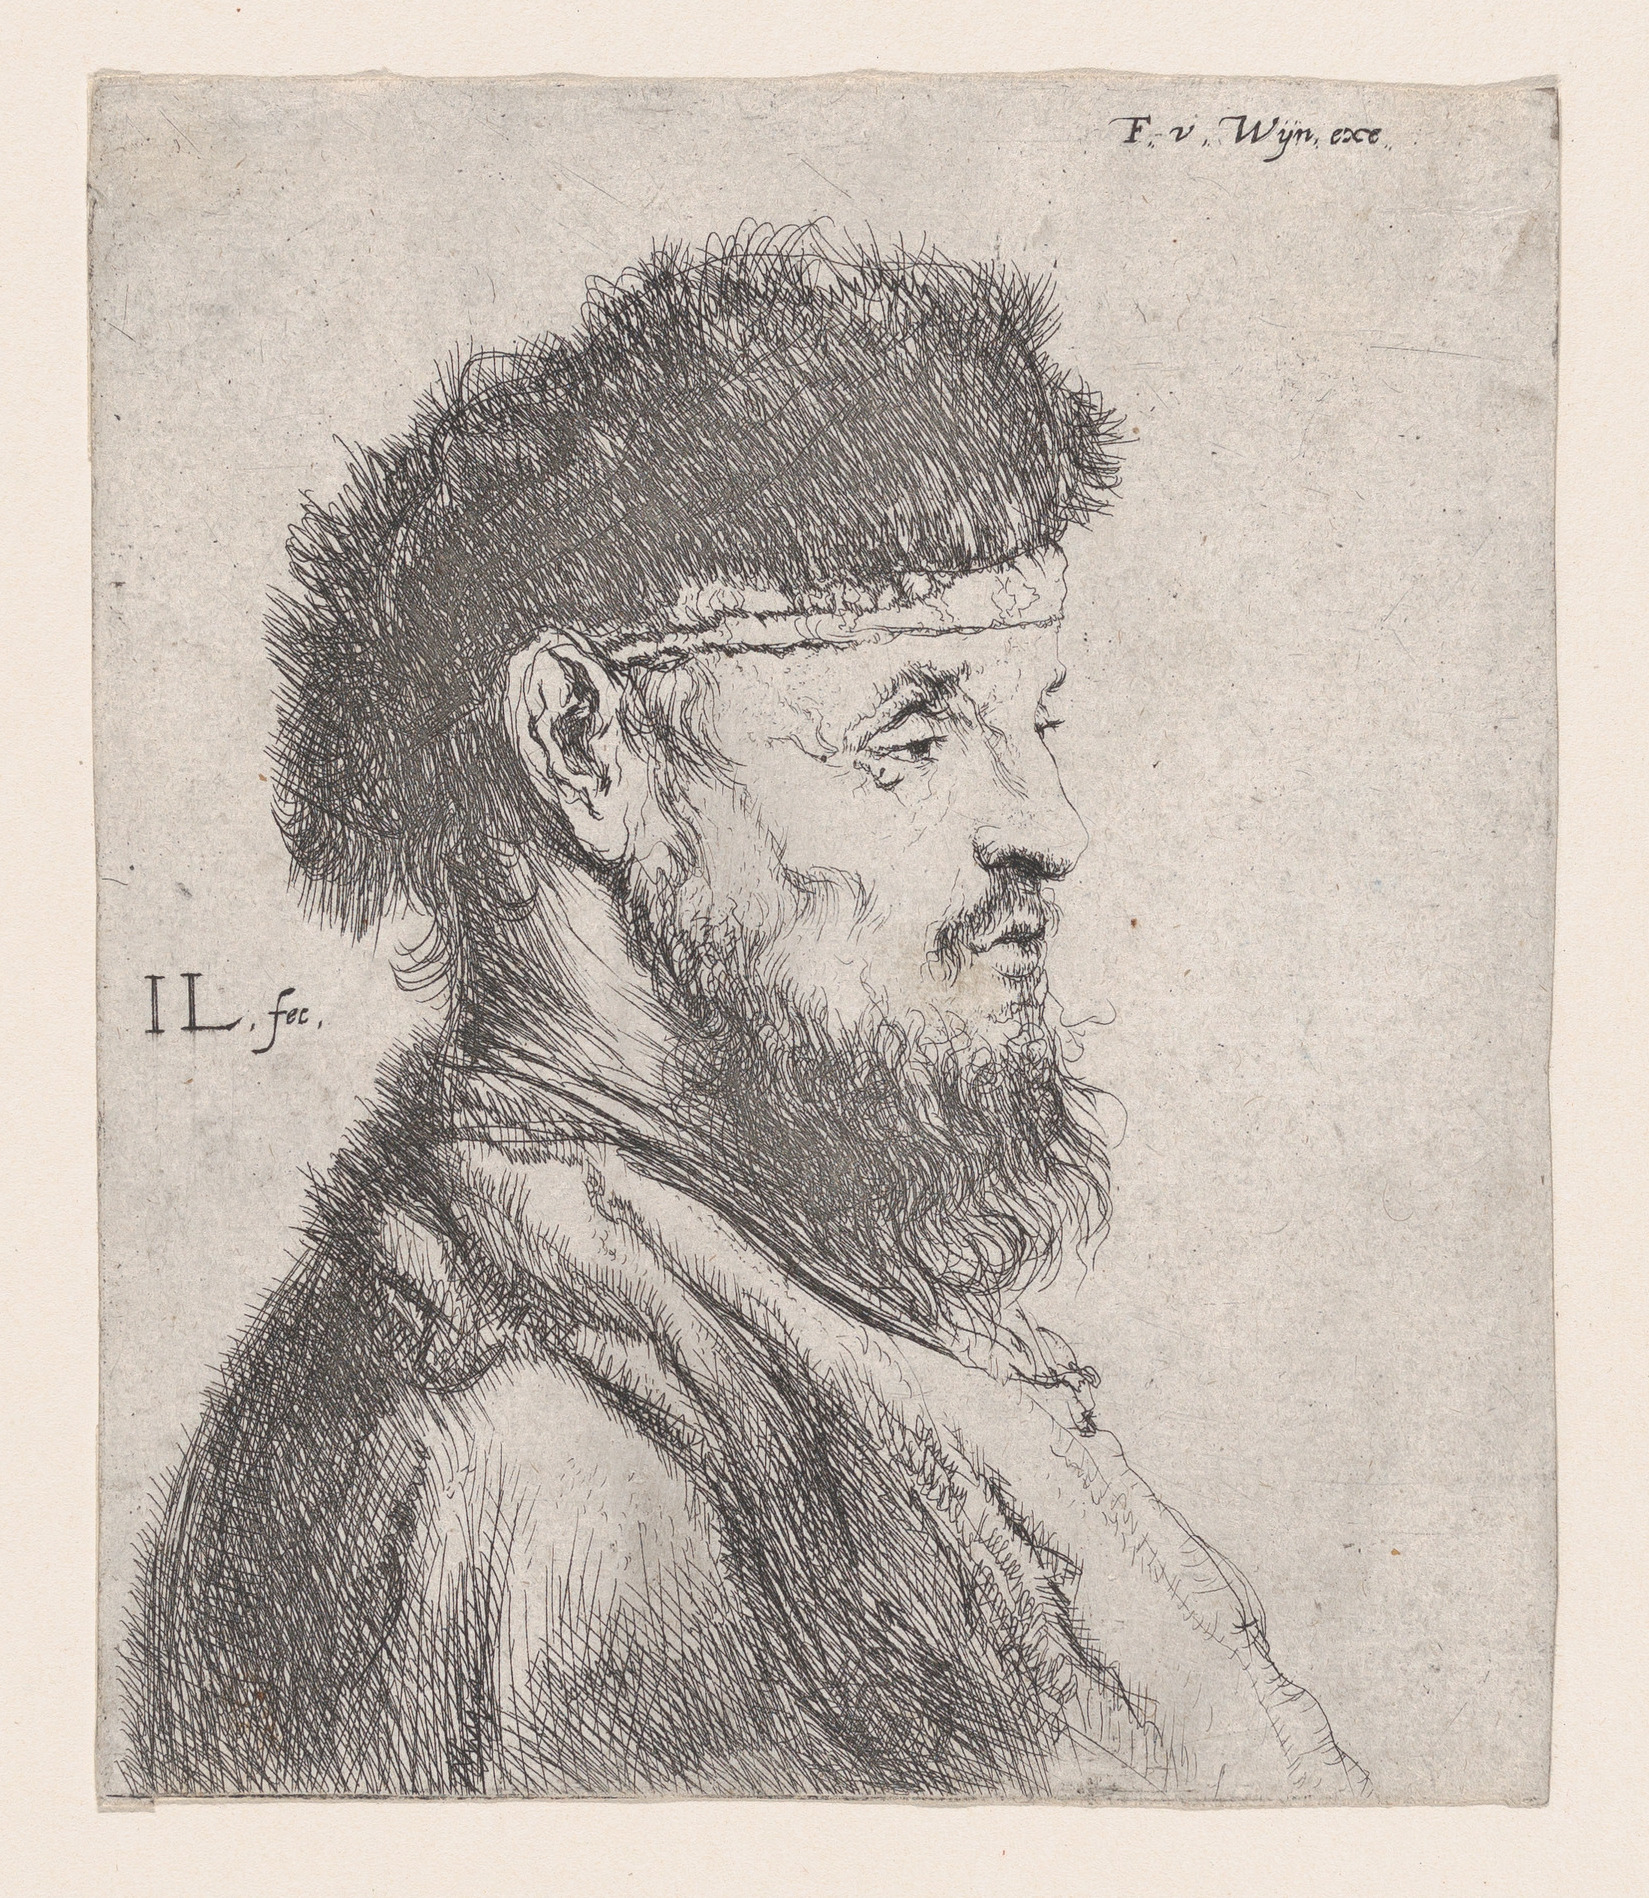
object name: print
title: Bust of a Man with a Fur Cap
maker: jan lievens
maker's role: artist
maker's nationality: dutch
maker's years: 1607-1674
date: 1601-1700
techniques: etching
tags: men,profiles